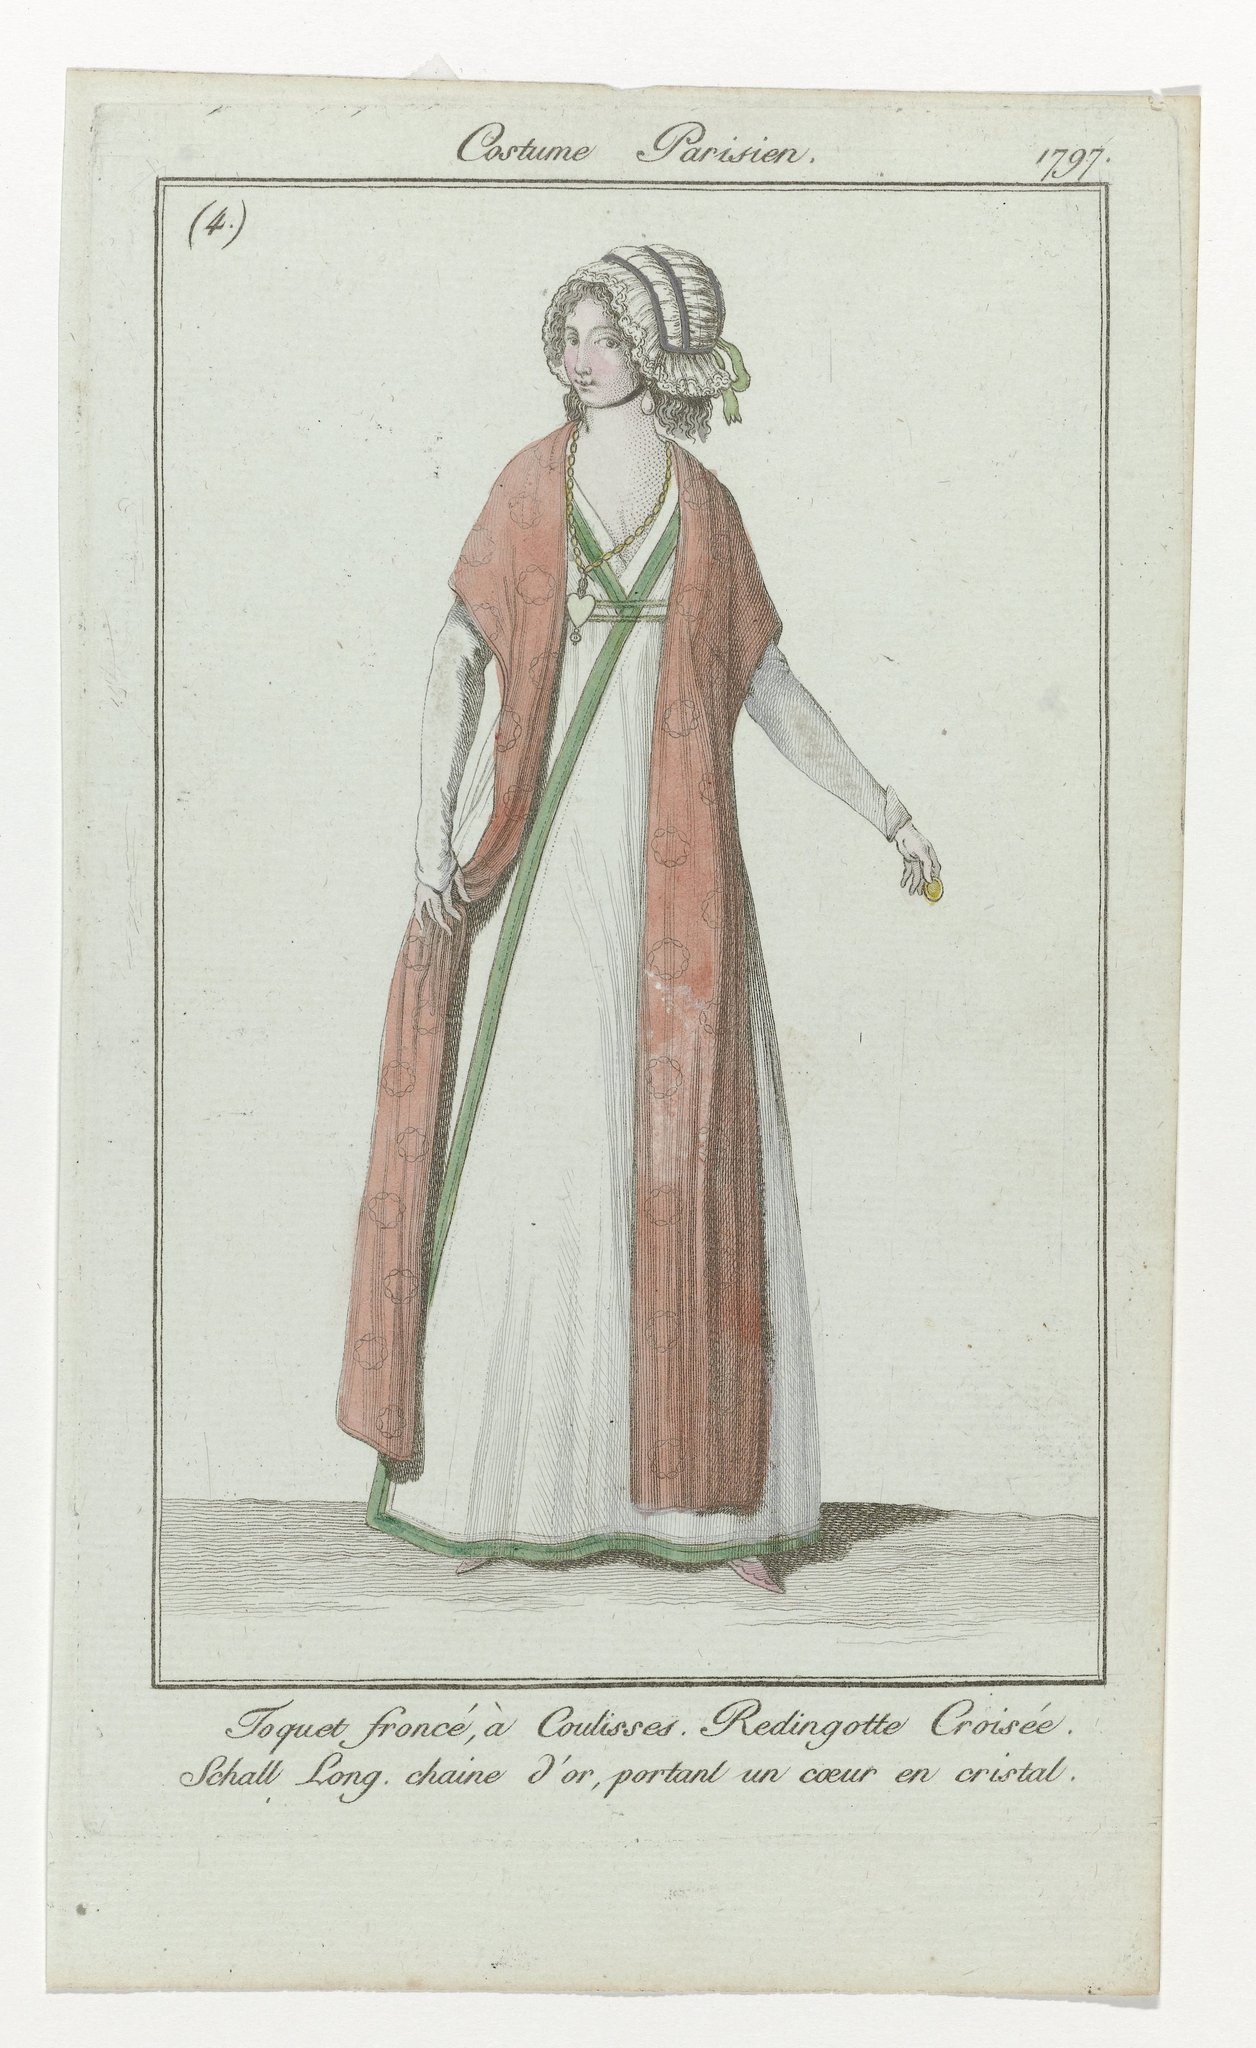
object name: fashion print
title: Journal des Dames et des Modes, Costume Parisien, août 1797, (4) : Toquet froncé à Coulisses (...)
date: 1797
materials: paper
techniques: engraving, hand coloring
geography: paris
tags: ear-rings (+ women's clothes), pendant, trinket, 'breloque' (+ women's clothes), head-gear: toque (+ women's clothes), clothing for the upper part of the body (shawl) (+ women's clothes), dress, gown: redingote (+ women's clothes), fashion plates, shoes, sandals (+ women's clothes), coin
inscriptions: title: ‘Costume Parisien.’, caption: ‘Toquet froncé à Coulisses. Redingotte Croisée. Schall Long. chaine d'or, portant un coeur en cristal.’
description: 'Toquet', aan de achterzijde gesmockt. Redingote met overslag. Om de schouders een lange sjaal met cirkelmotief. Gouden collier met hartvormige hanger van kristal. Verdere accessoires: oorbel in het linkeroor, schoenen met puntige neuzen. De prent maakt deel uit van het modetijdschrift Journal des Dames et des Modes, uitgegeven door Sellèque, Parijs, 1797-1839. De prent werd eerder uitgegeven in het Journal des Modes et Nouveautés als nummer 4, met het onderschrift 'Costumes'.